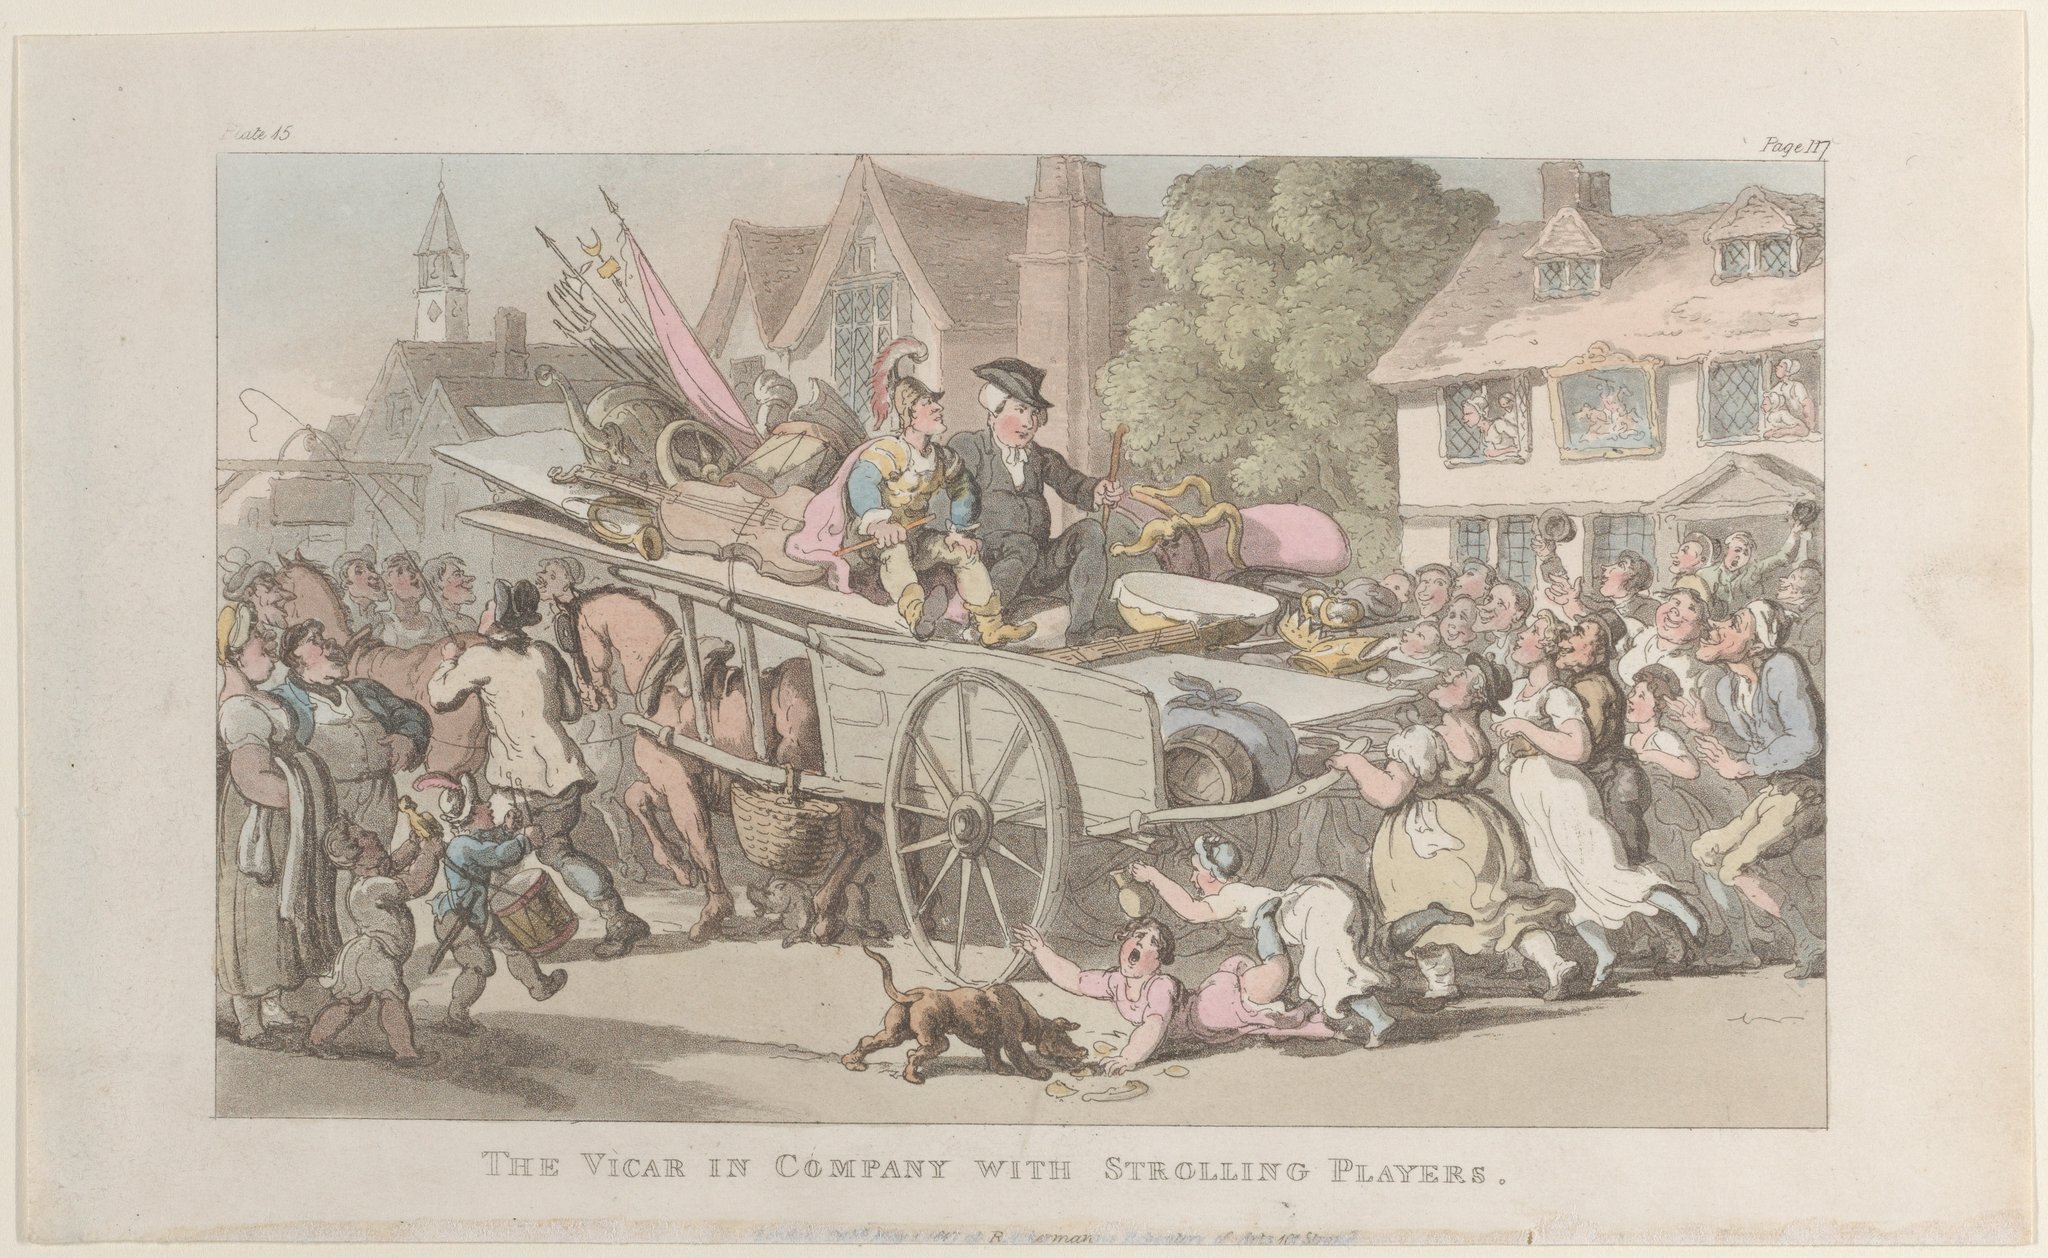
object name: print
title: The Vicar in company with Strolling Players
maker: thomas rowlandson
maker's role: artist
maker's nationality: british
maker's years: 1757-1827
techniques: aquatint, etching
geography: london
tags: men,women,dogs,horses,carts